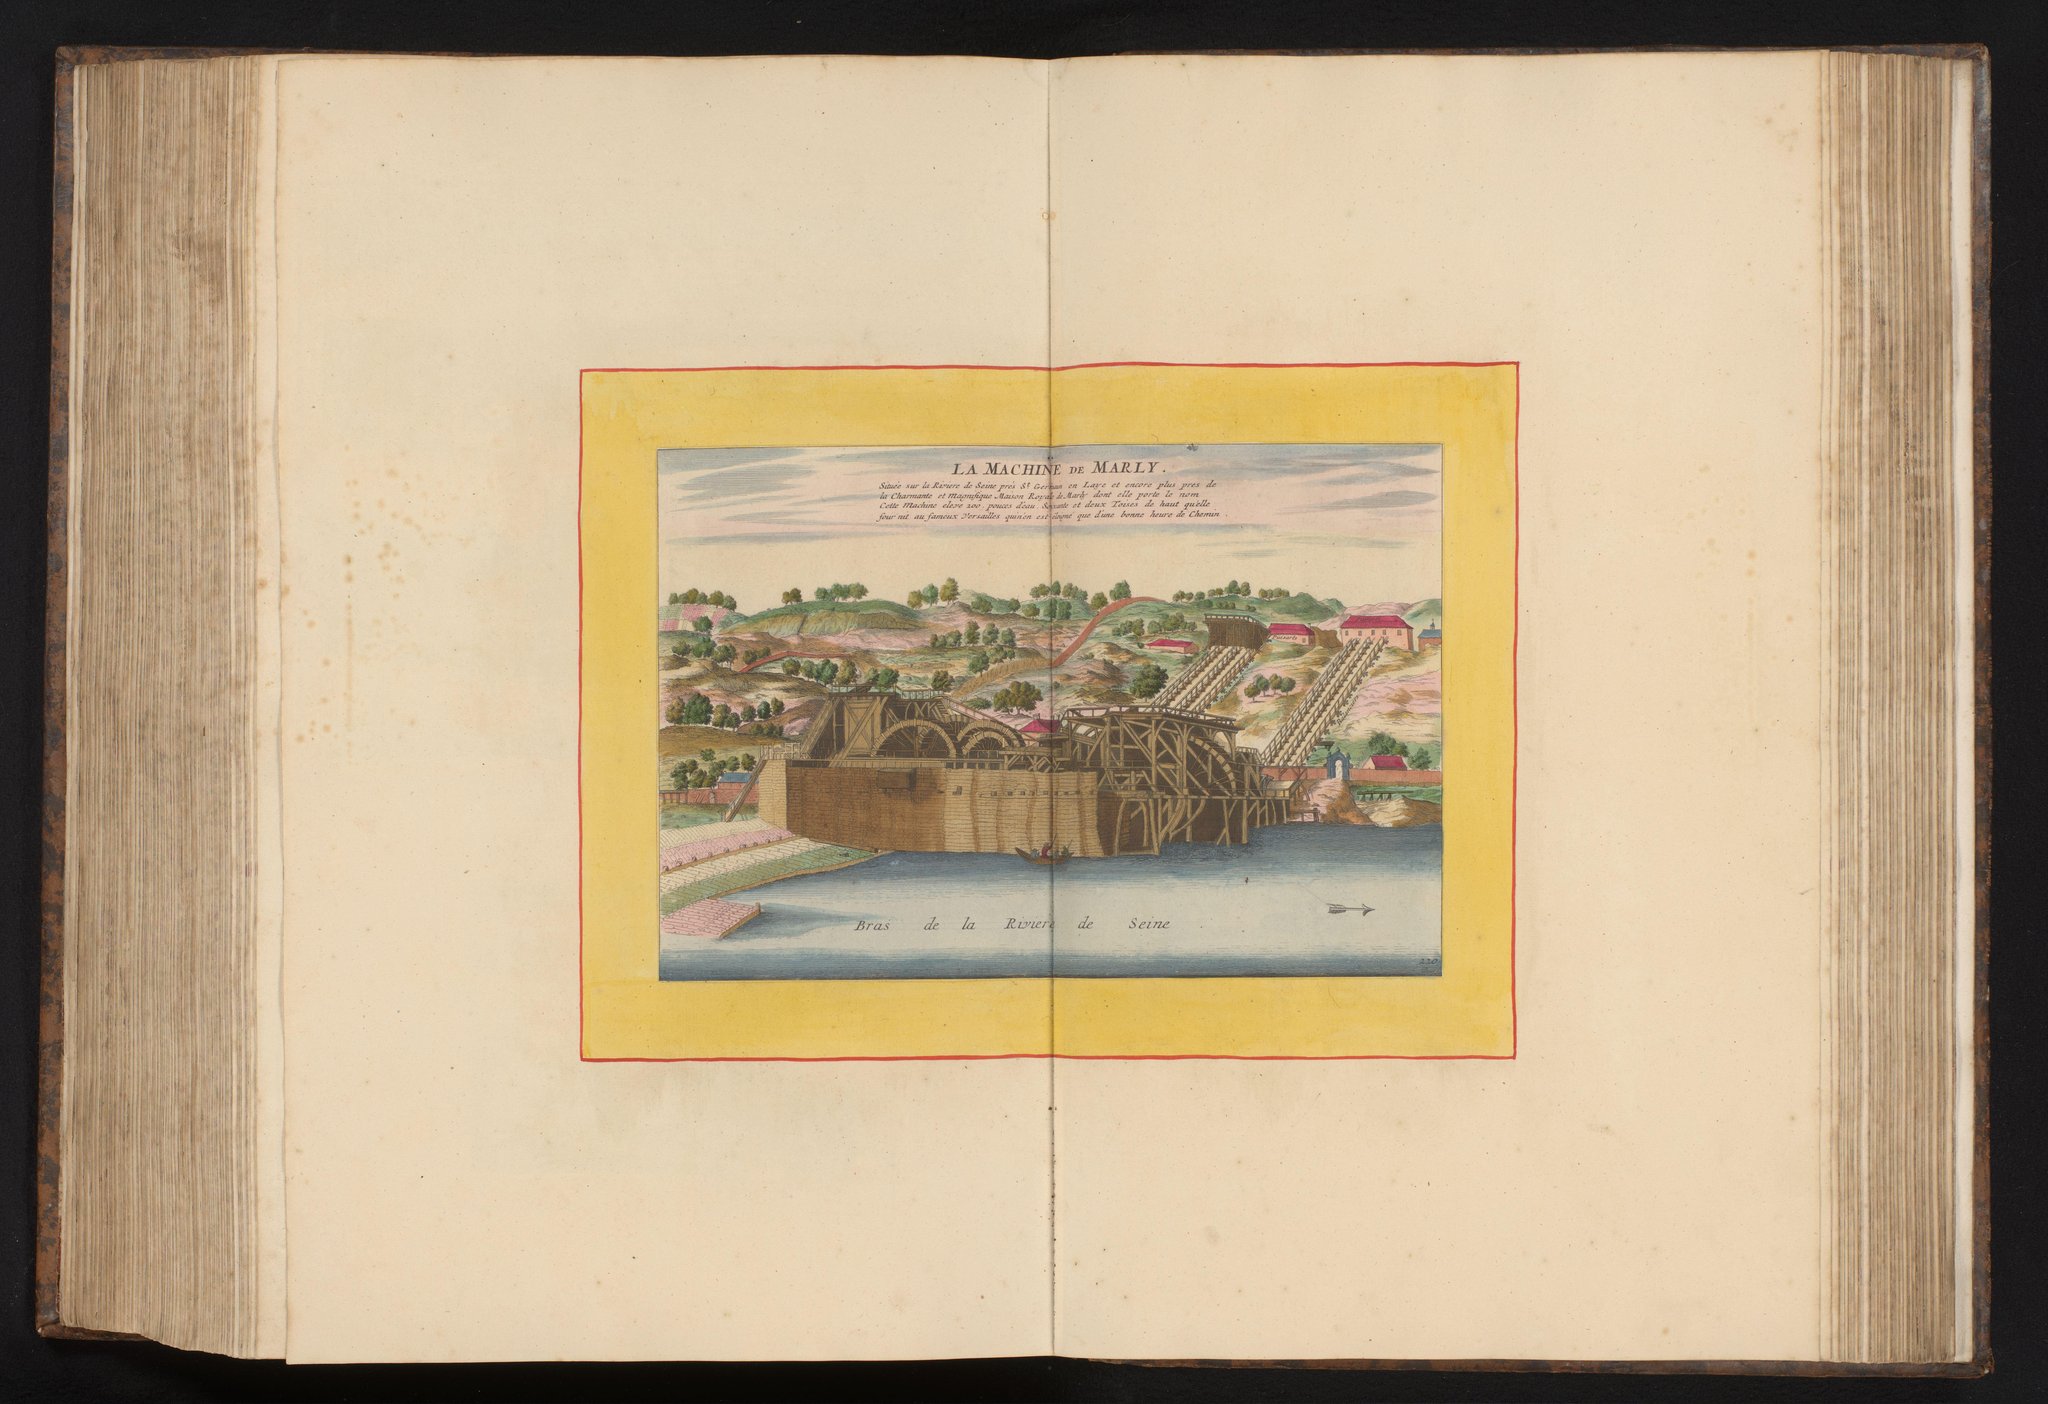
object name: print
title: La Machine de Marly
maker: anna beeck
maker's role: publisher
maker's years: 1657-1717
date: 1702-1703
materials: paper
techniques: etching, hand coloring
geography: the hague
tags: river, pump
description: De Machine van Marly. Pompinstallatie voltooid in 1684 om water vanuit de Seine naar de tuinen van het paleis van Versailles te pompen. Plaat nr. 220 afkomstig uit een prentwerk bestaande in totaal uit 276 genummerde platen van vermaarde sterke steden en vestingen in het kader van de Spaanse Successieoorlog. Voor het merendeel zijn deze platen gekopieerd naar de anonieme Franse platen: in Les forces de l'Europe en in: Le theatre de la guerre, dans les Pays-Bas, beide oorspronkelijk uitgegeven door Nicolas de Fer te Parijs (1693-1697) in het kader van de Negenjarige Oorlog. Titel en opschriften in de plaat in het Frans. Prent maakt deel uit van een album.